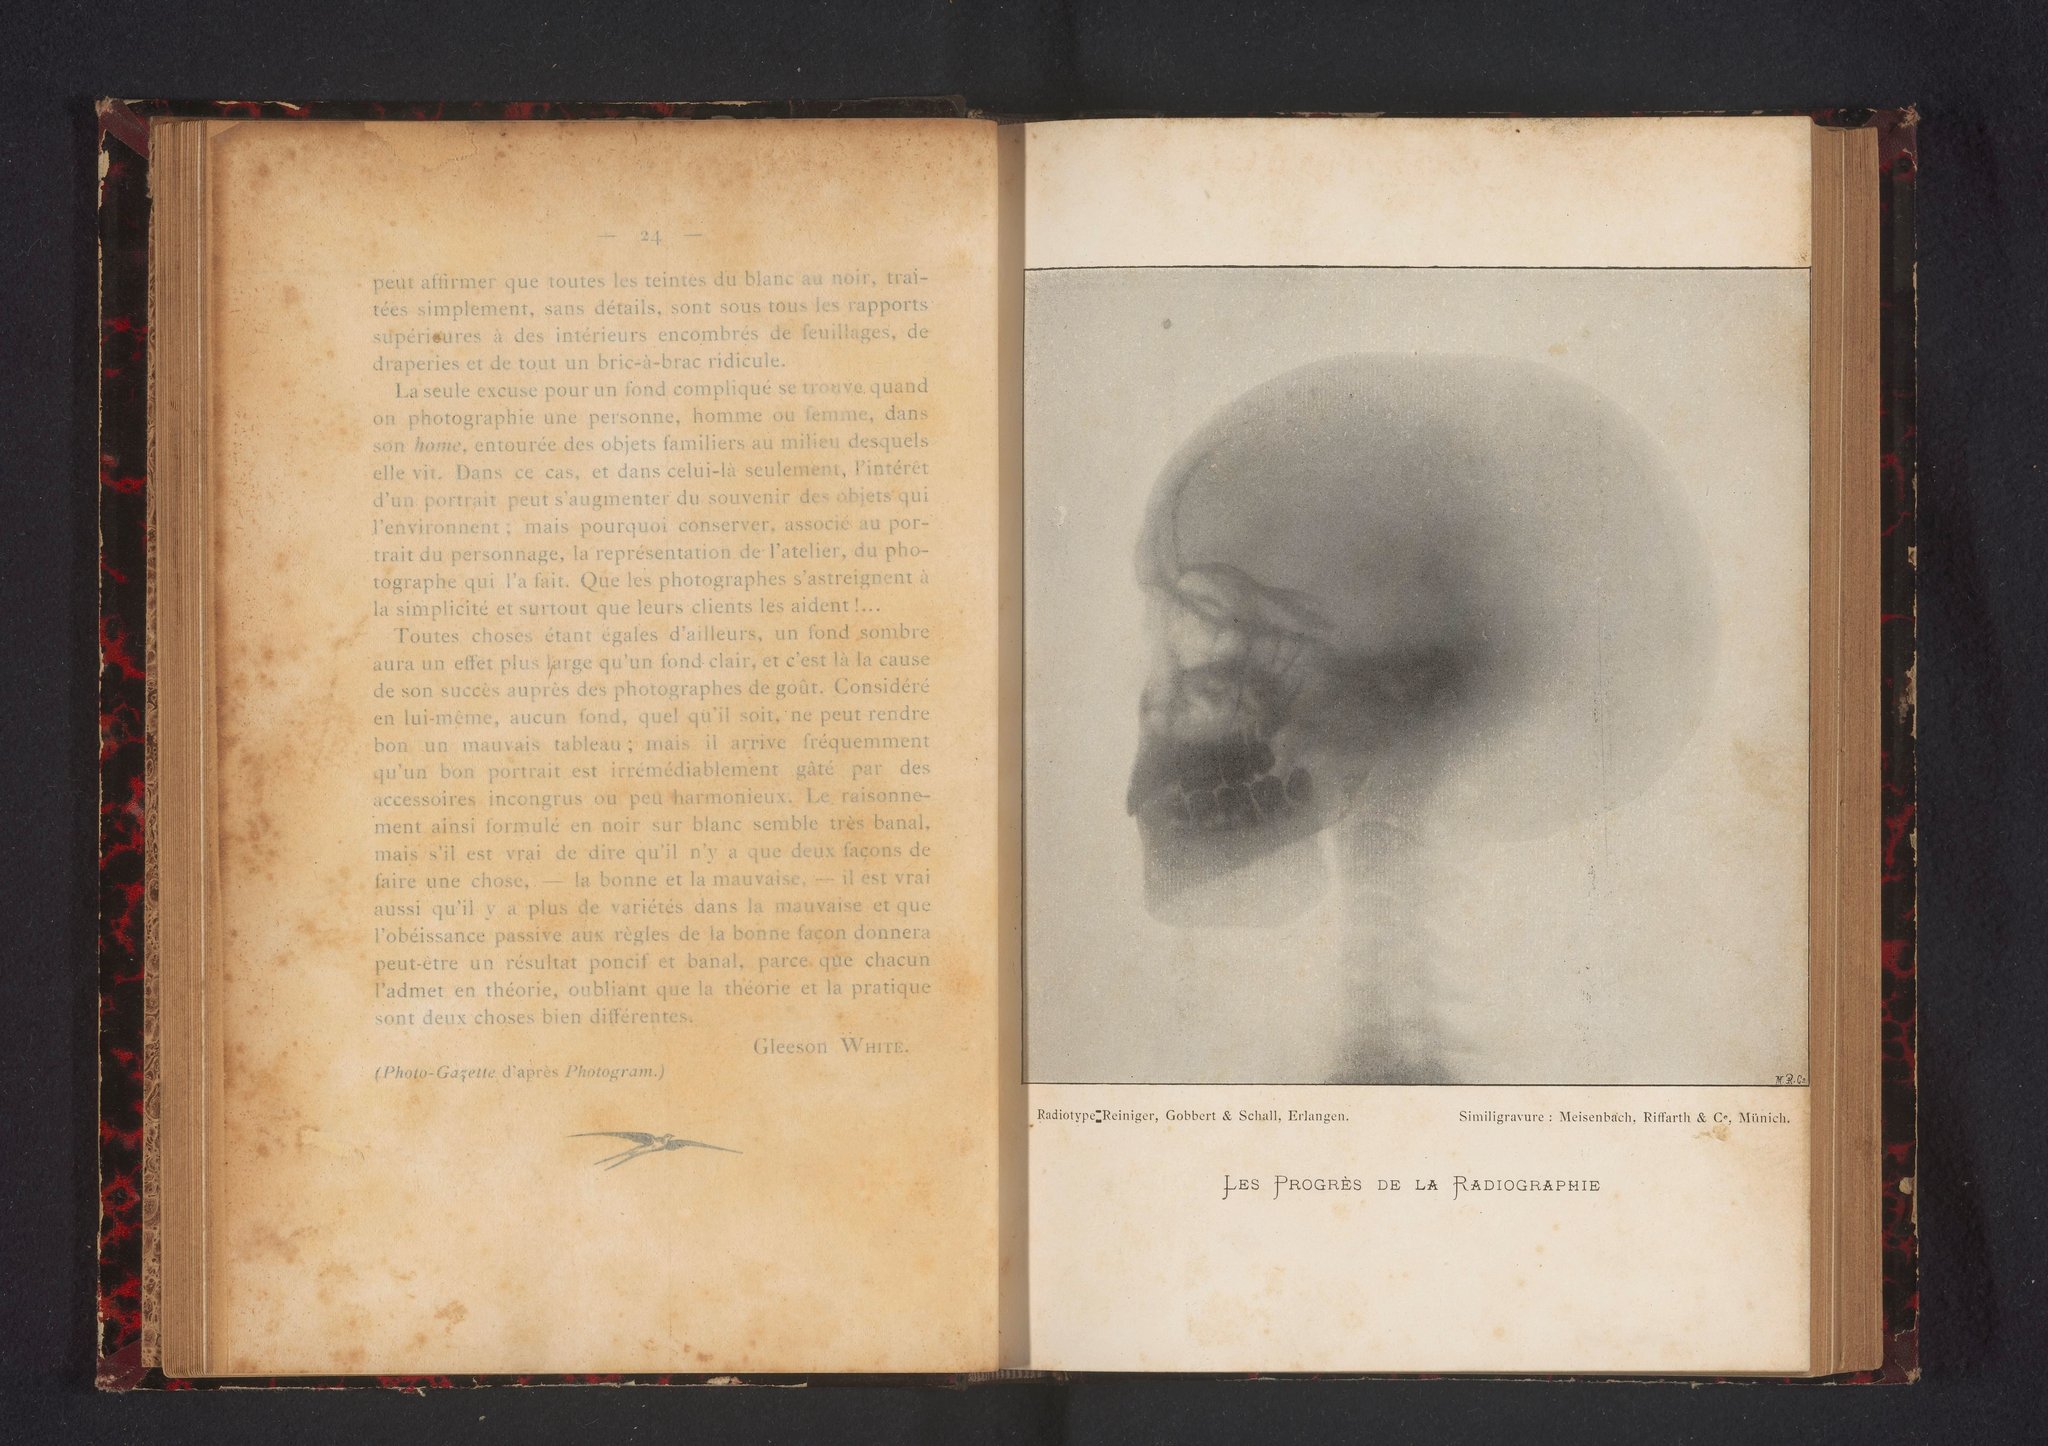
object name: page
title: Röntgenfoto van een menselijke schedel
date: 1893-1898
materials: paper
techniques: autotype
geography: munich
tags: (human) skull, x-ray examination